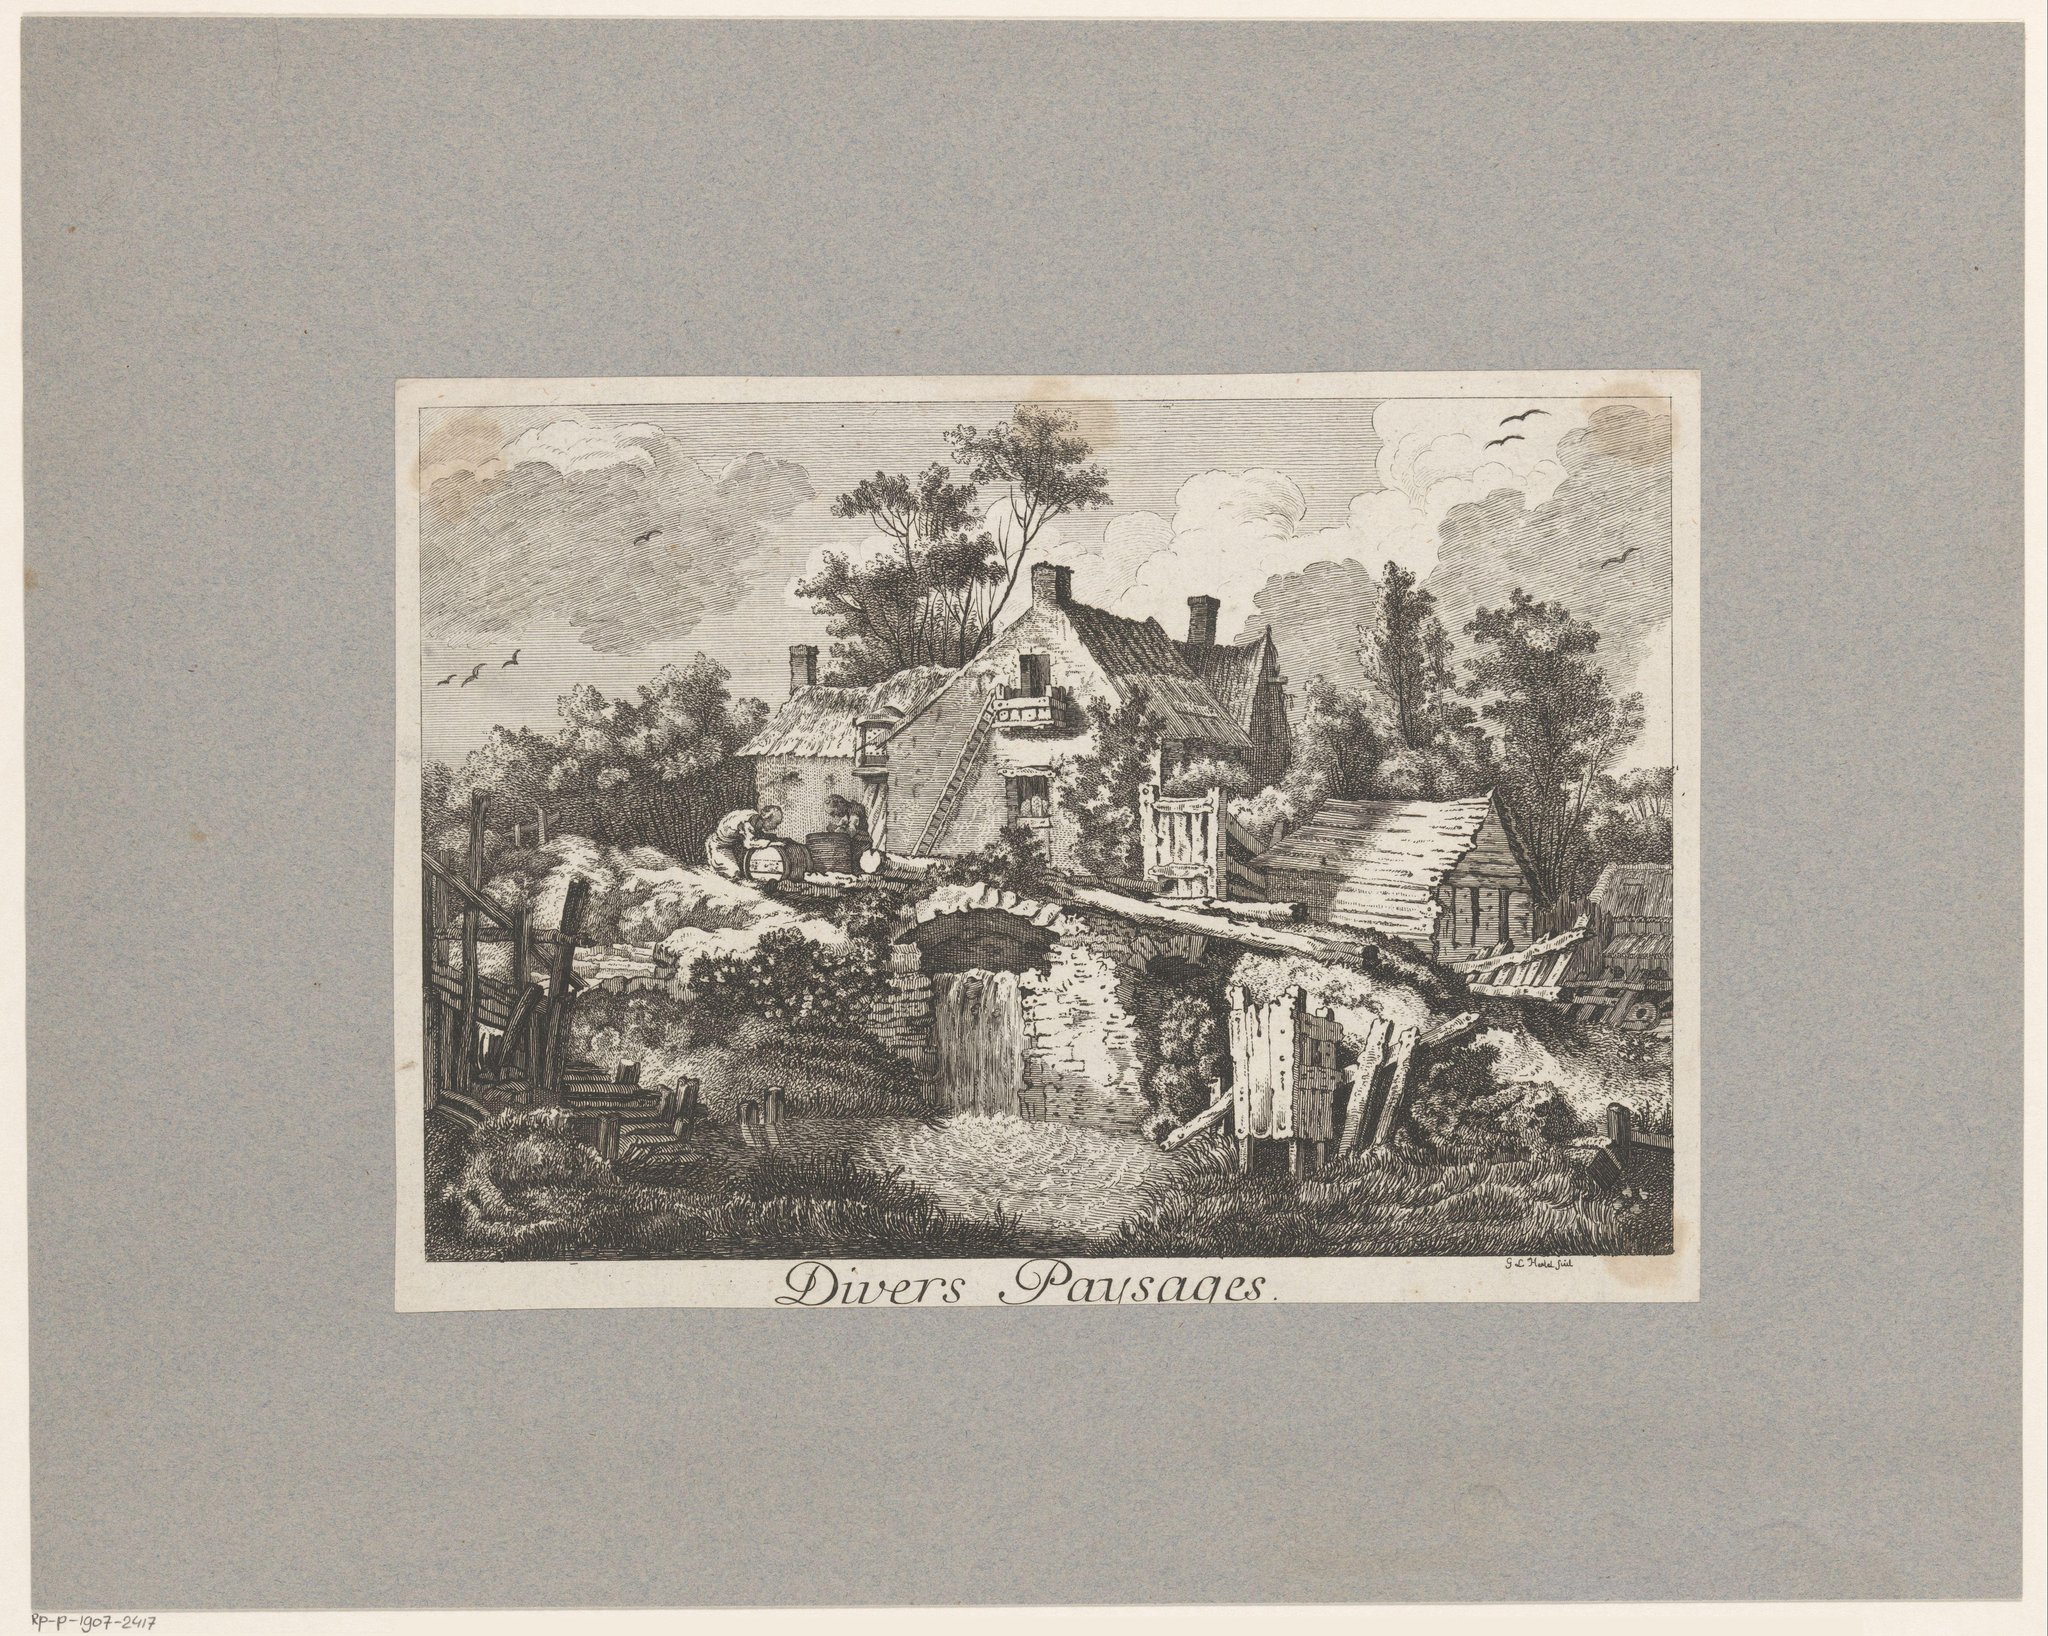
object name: print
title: Landschap met twee kuipers voor een huis omringd door houten constructies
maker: georg leopold hertel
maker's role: print maker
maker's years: 1740-1778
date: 1750-1778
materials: paper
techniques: etching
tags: wooden container: barrel, cask, bucket, farm or solitary house in landscape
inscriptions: collector's mark: Lugt 2228